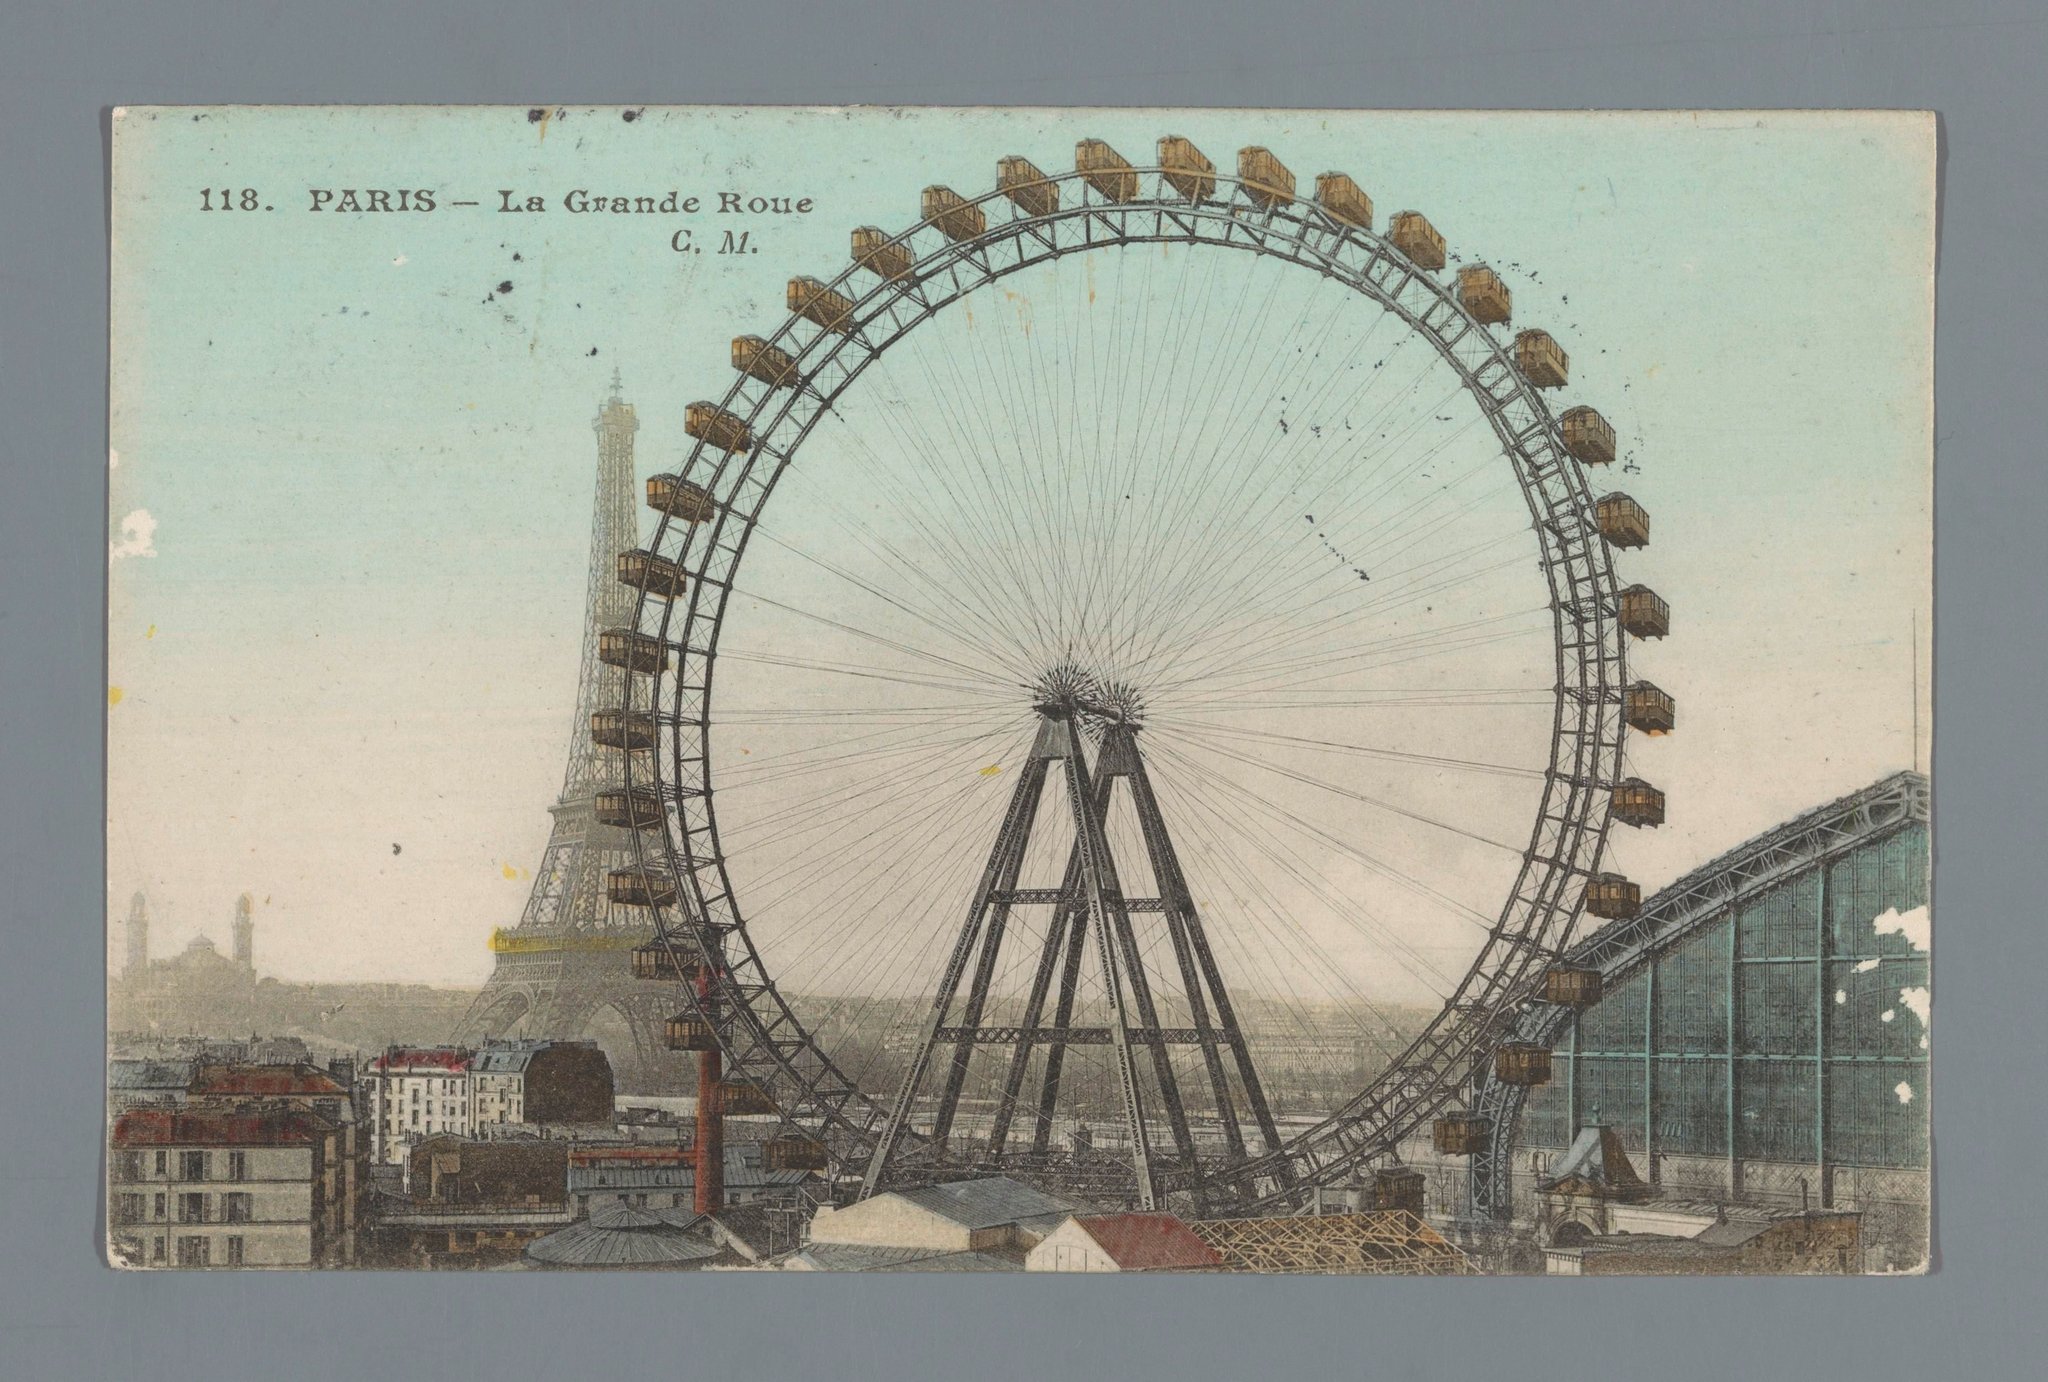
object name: ansichtkaart, prentbriefkaart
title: Paris - La Grande Roue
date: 1907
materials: paper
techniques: photograph, lithograph, writing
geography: paris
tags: city-view in general; 'veduta', giant wheel, ferris wheel, paris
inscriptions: number: ‘118’